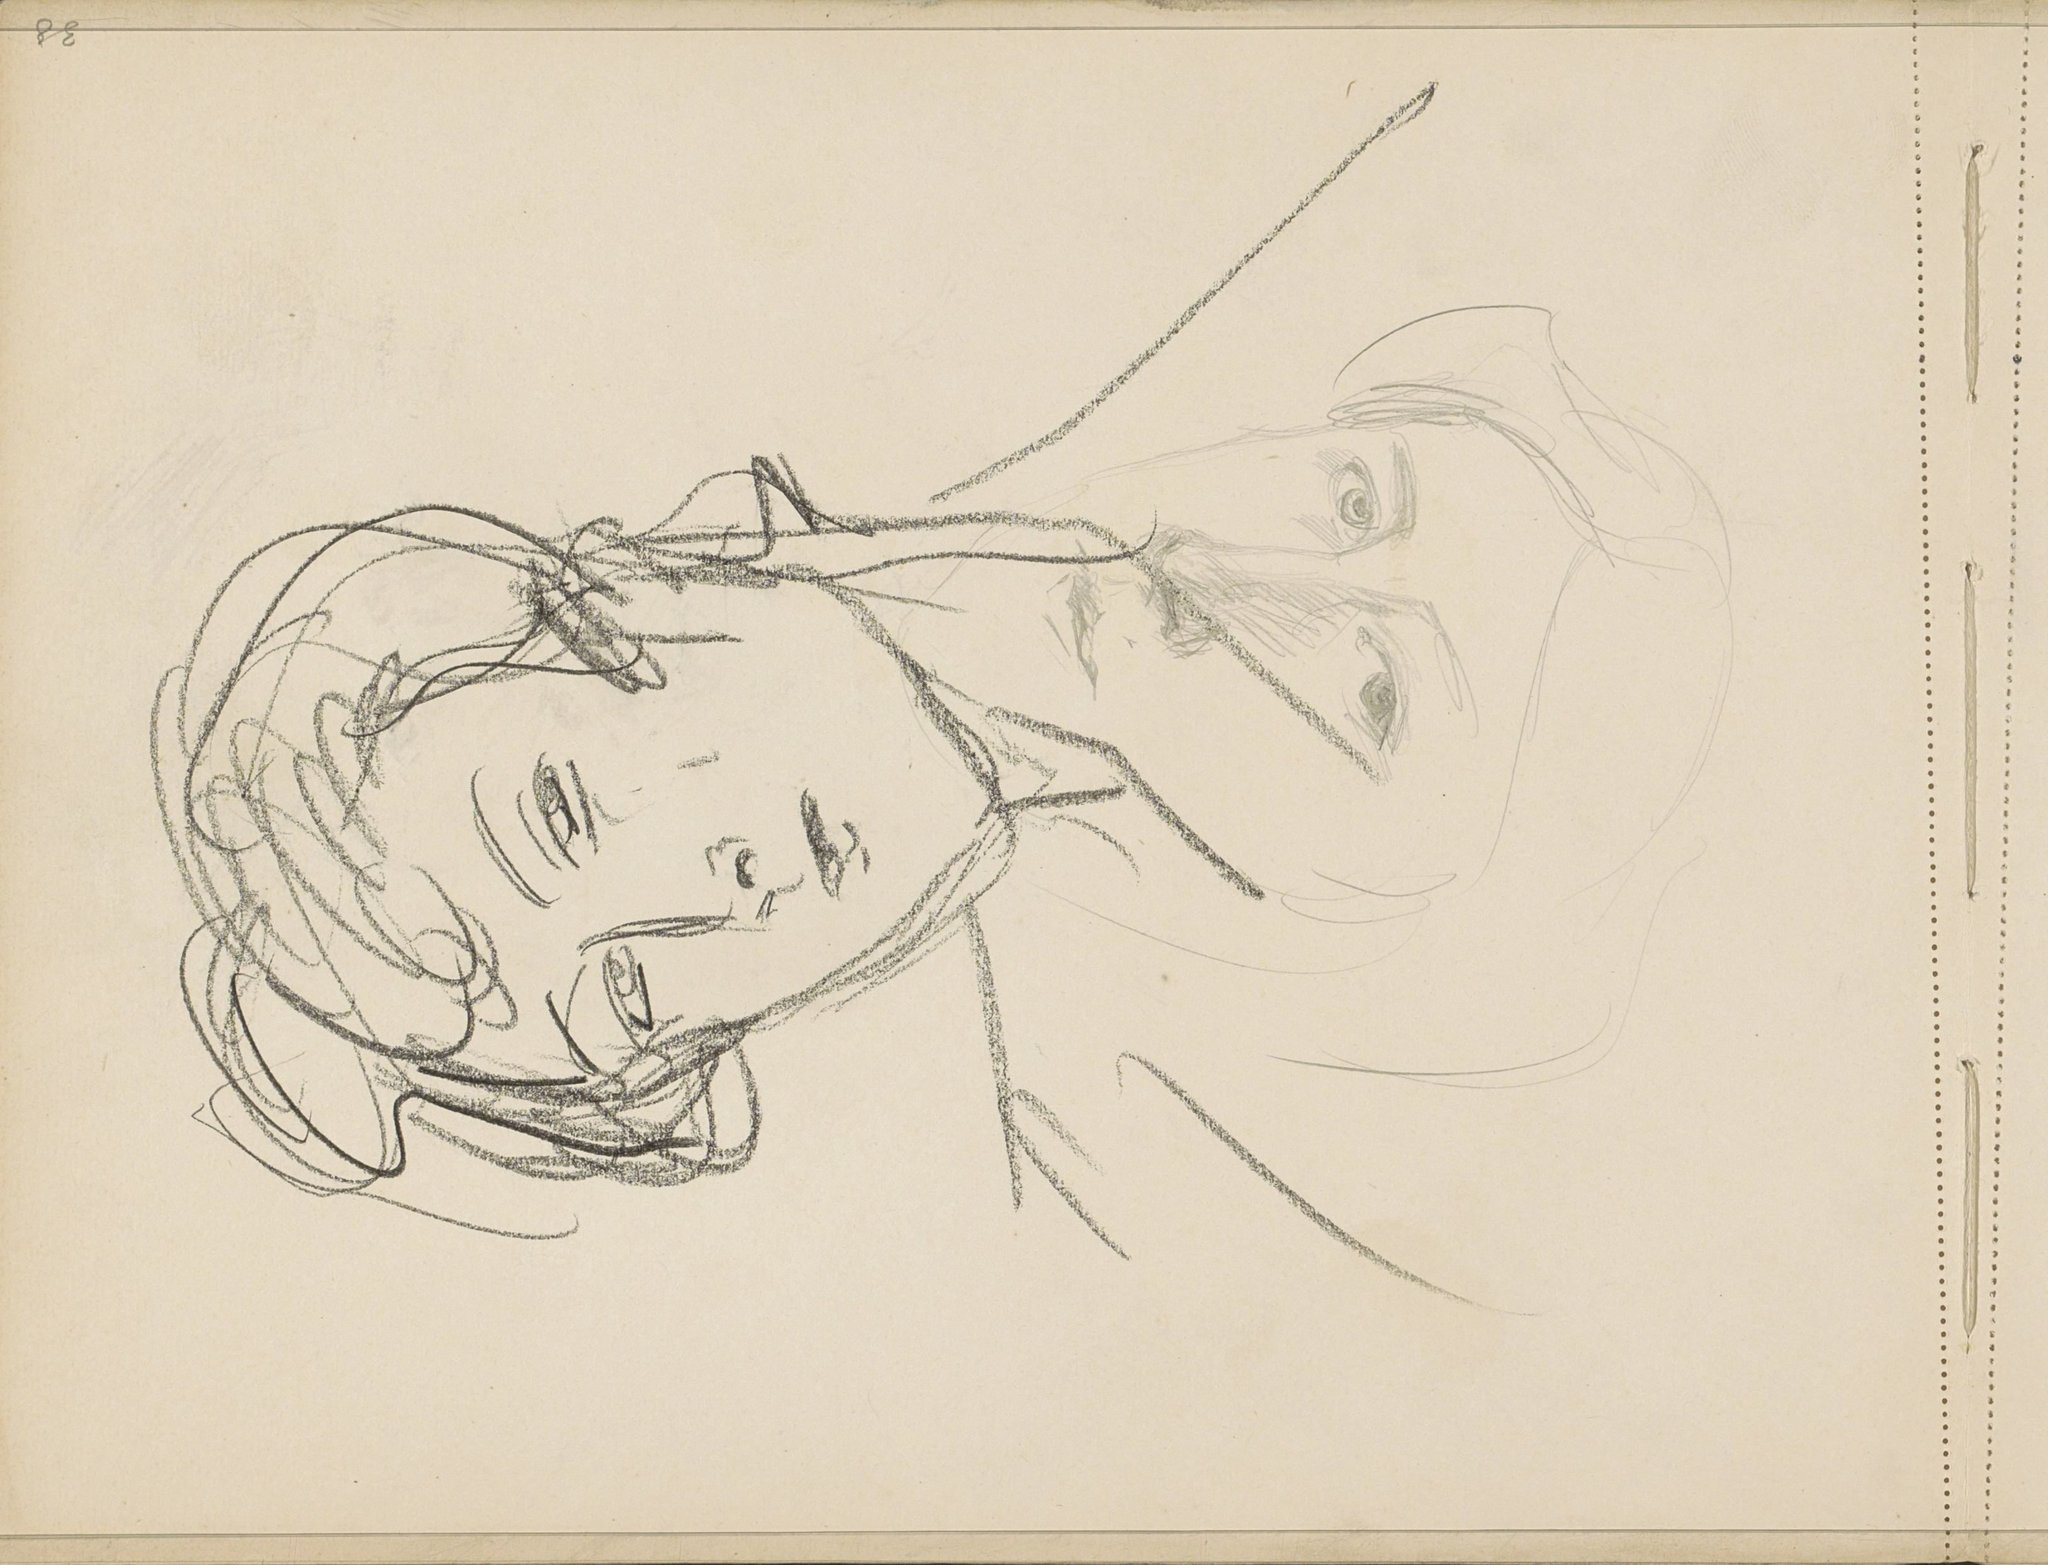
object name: sketchbook leaf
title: Twee vrouwenhoofden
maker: isaac israels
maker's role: draughtsman, painter, print maker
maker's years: 1865-1934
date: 1875-1934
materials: chalk, paper, pencil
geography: the hague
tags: head (human) - aa - female human figure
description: Blad 4 verso uit schetsboek XXIII met 20 bladen.